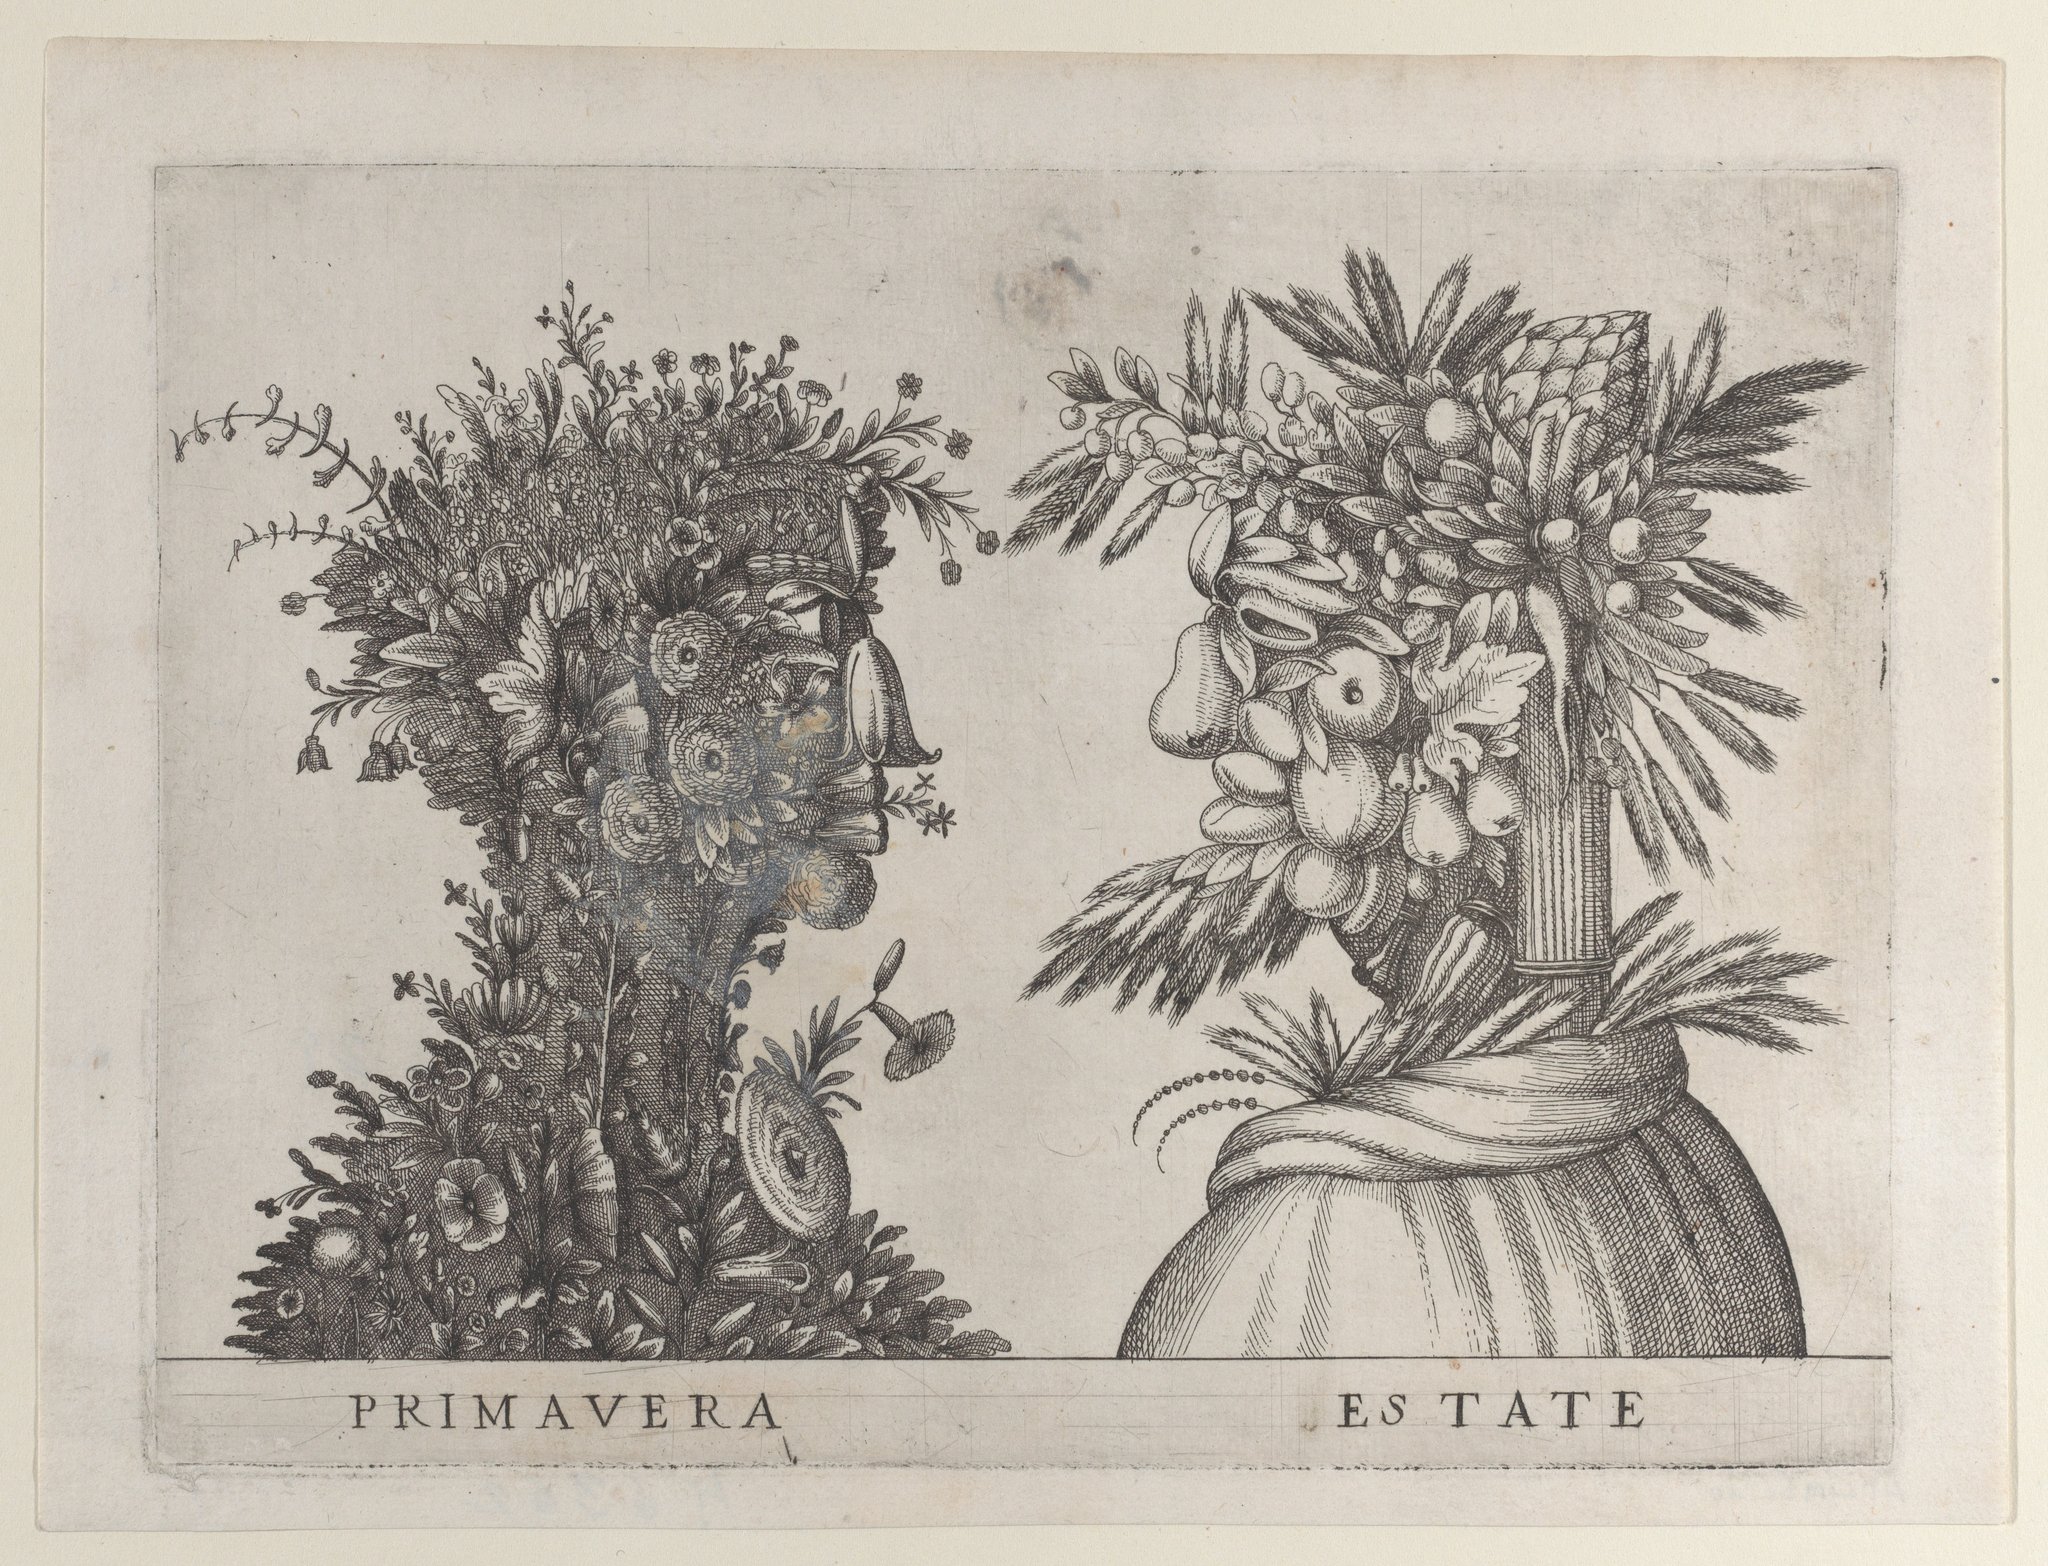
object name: print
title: Spring and Summer: two heads made from flora typical of those seasons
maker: anonymous, italian, 16th to early 17th century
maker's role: artist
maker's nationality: italian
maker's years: 1500-1640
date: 1580-1620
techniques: etching